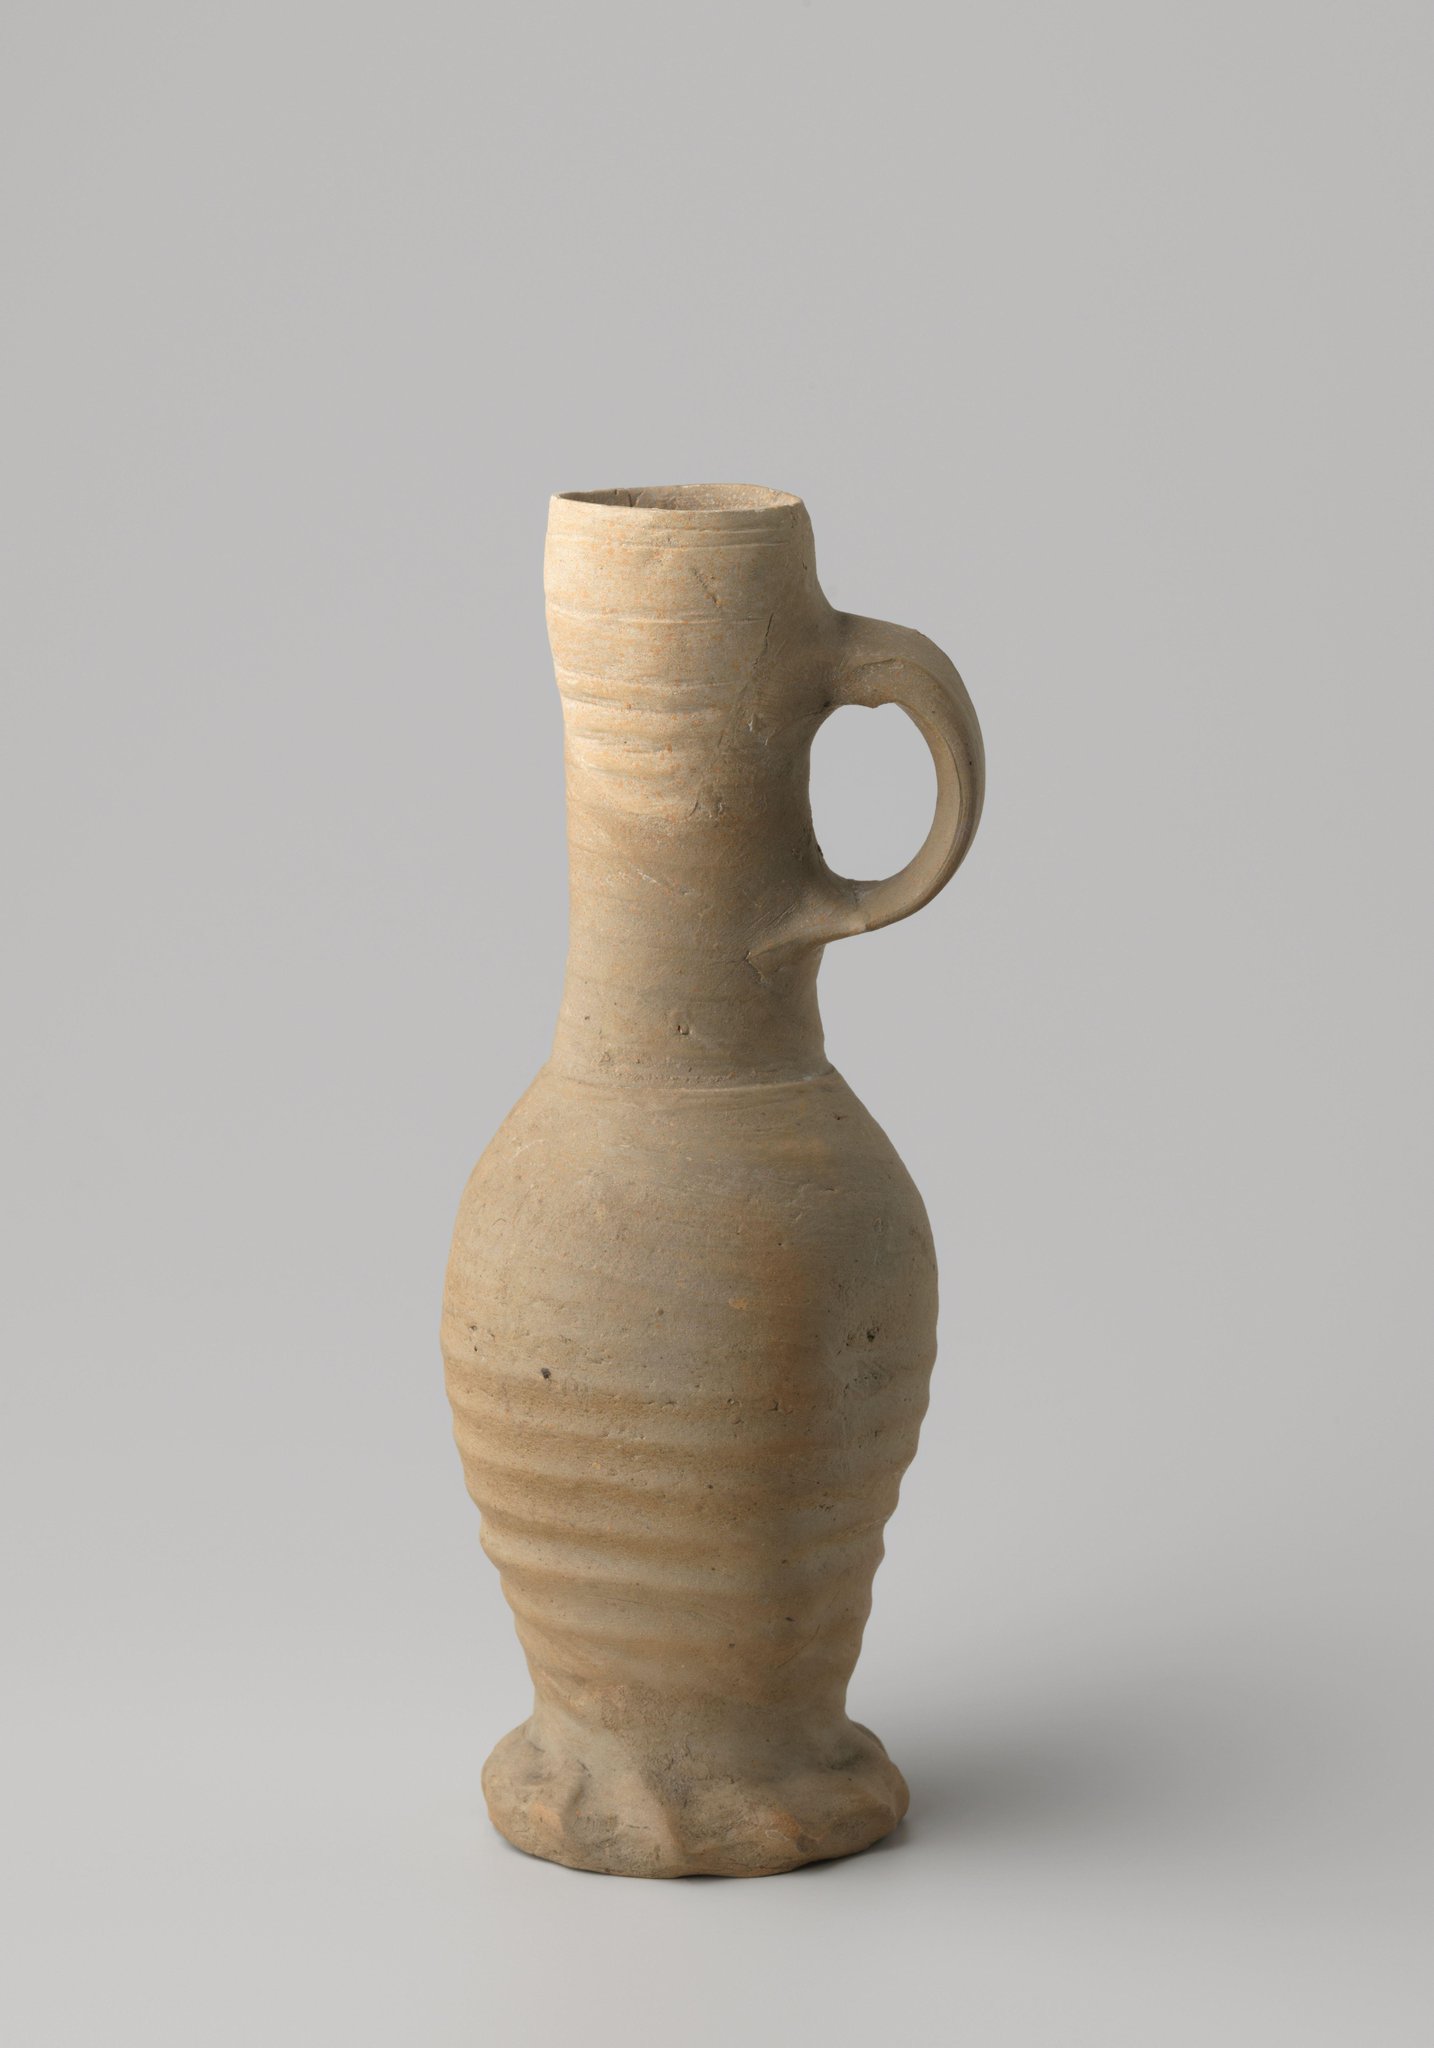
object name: ewer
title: Jug or 'Jacobakan'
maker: Anonymous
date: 1450-1599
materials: stoneware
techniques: firing, forming, turning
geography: germany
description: Geribde, smalle kan (Jacobakan) van steengoed op gegolfde voet met een eivormig lichaam en lange nek. Het C-vormige oor is bevestigd aan de nek. De kan is versierd met draairingen en een profiel op de schouder.